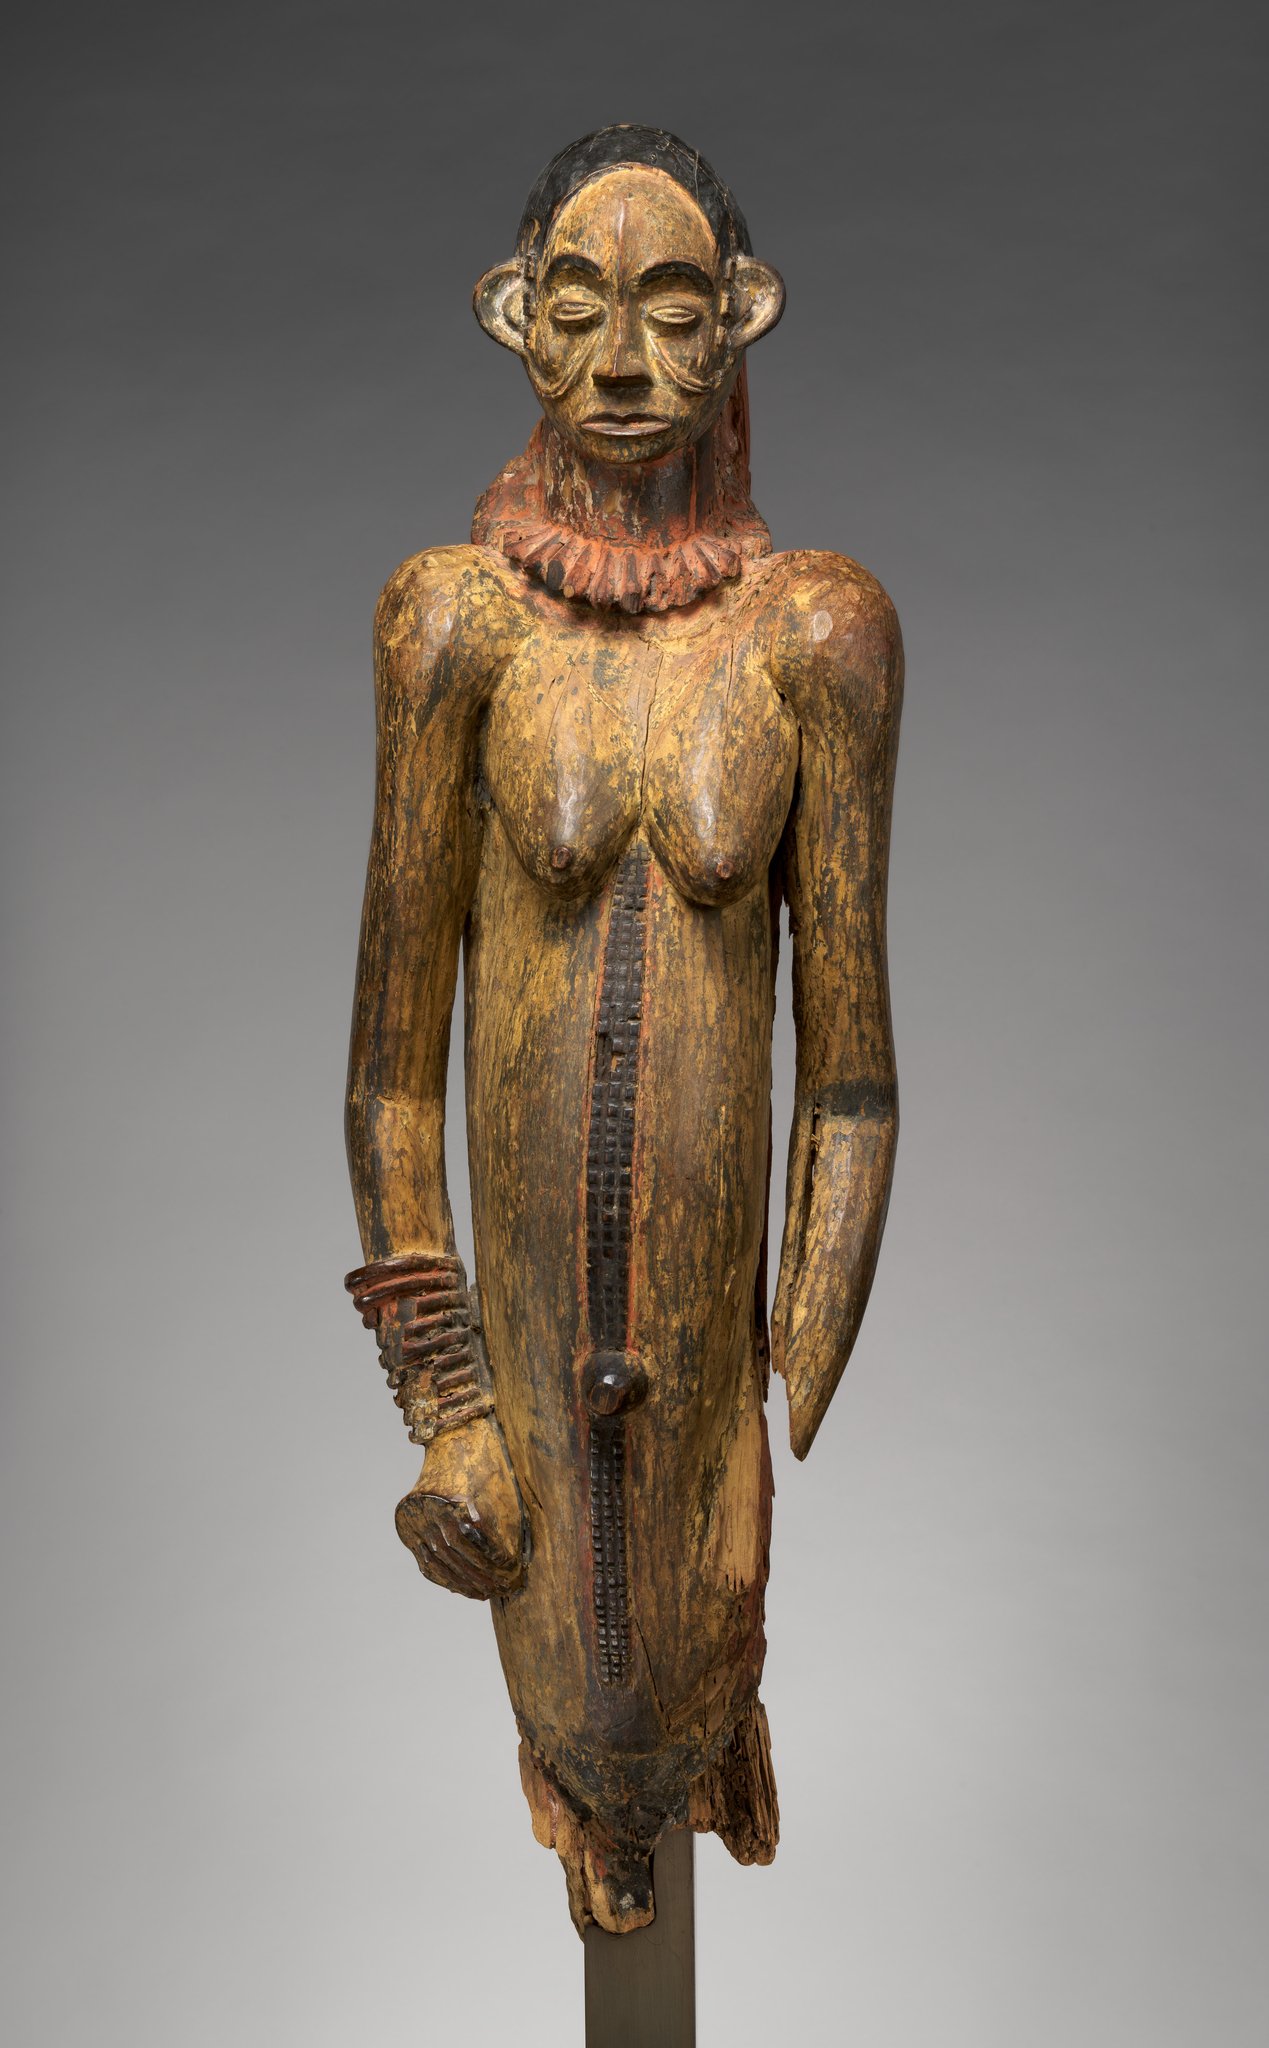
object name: figure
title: Female figure from an obu (house of images)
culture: igbo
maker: igbo artist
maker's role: artist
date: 1867-1900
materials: pigment, wood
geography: nigeria